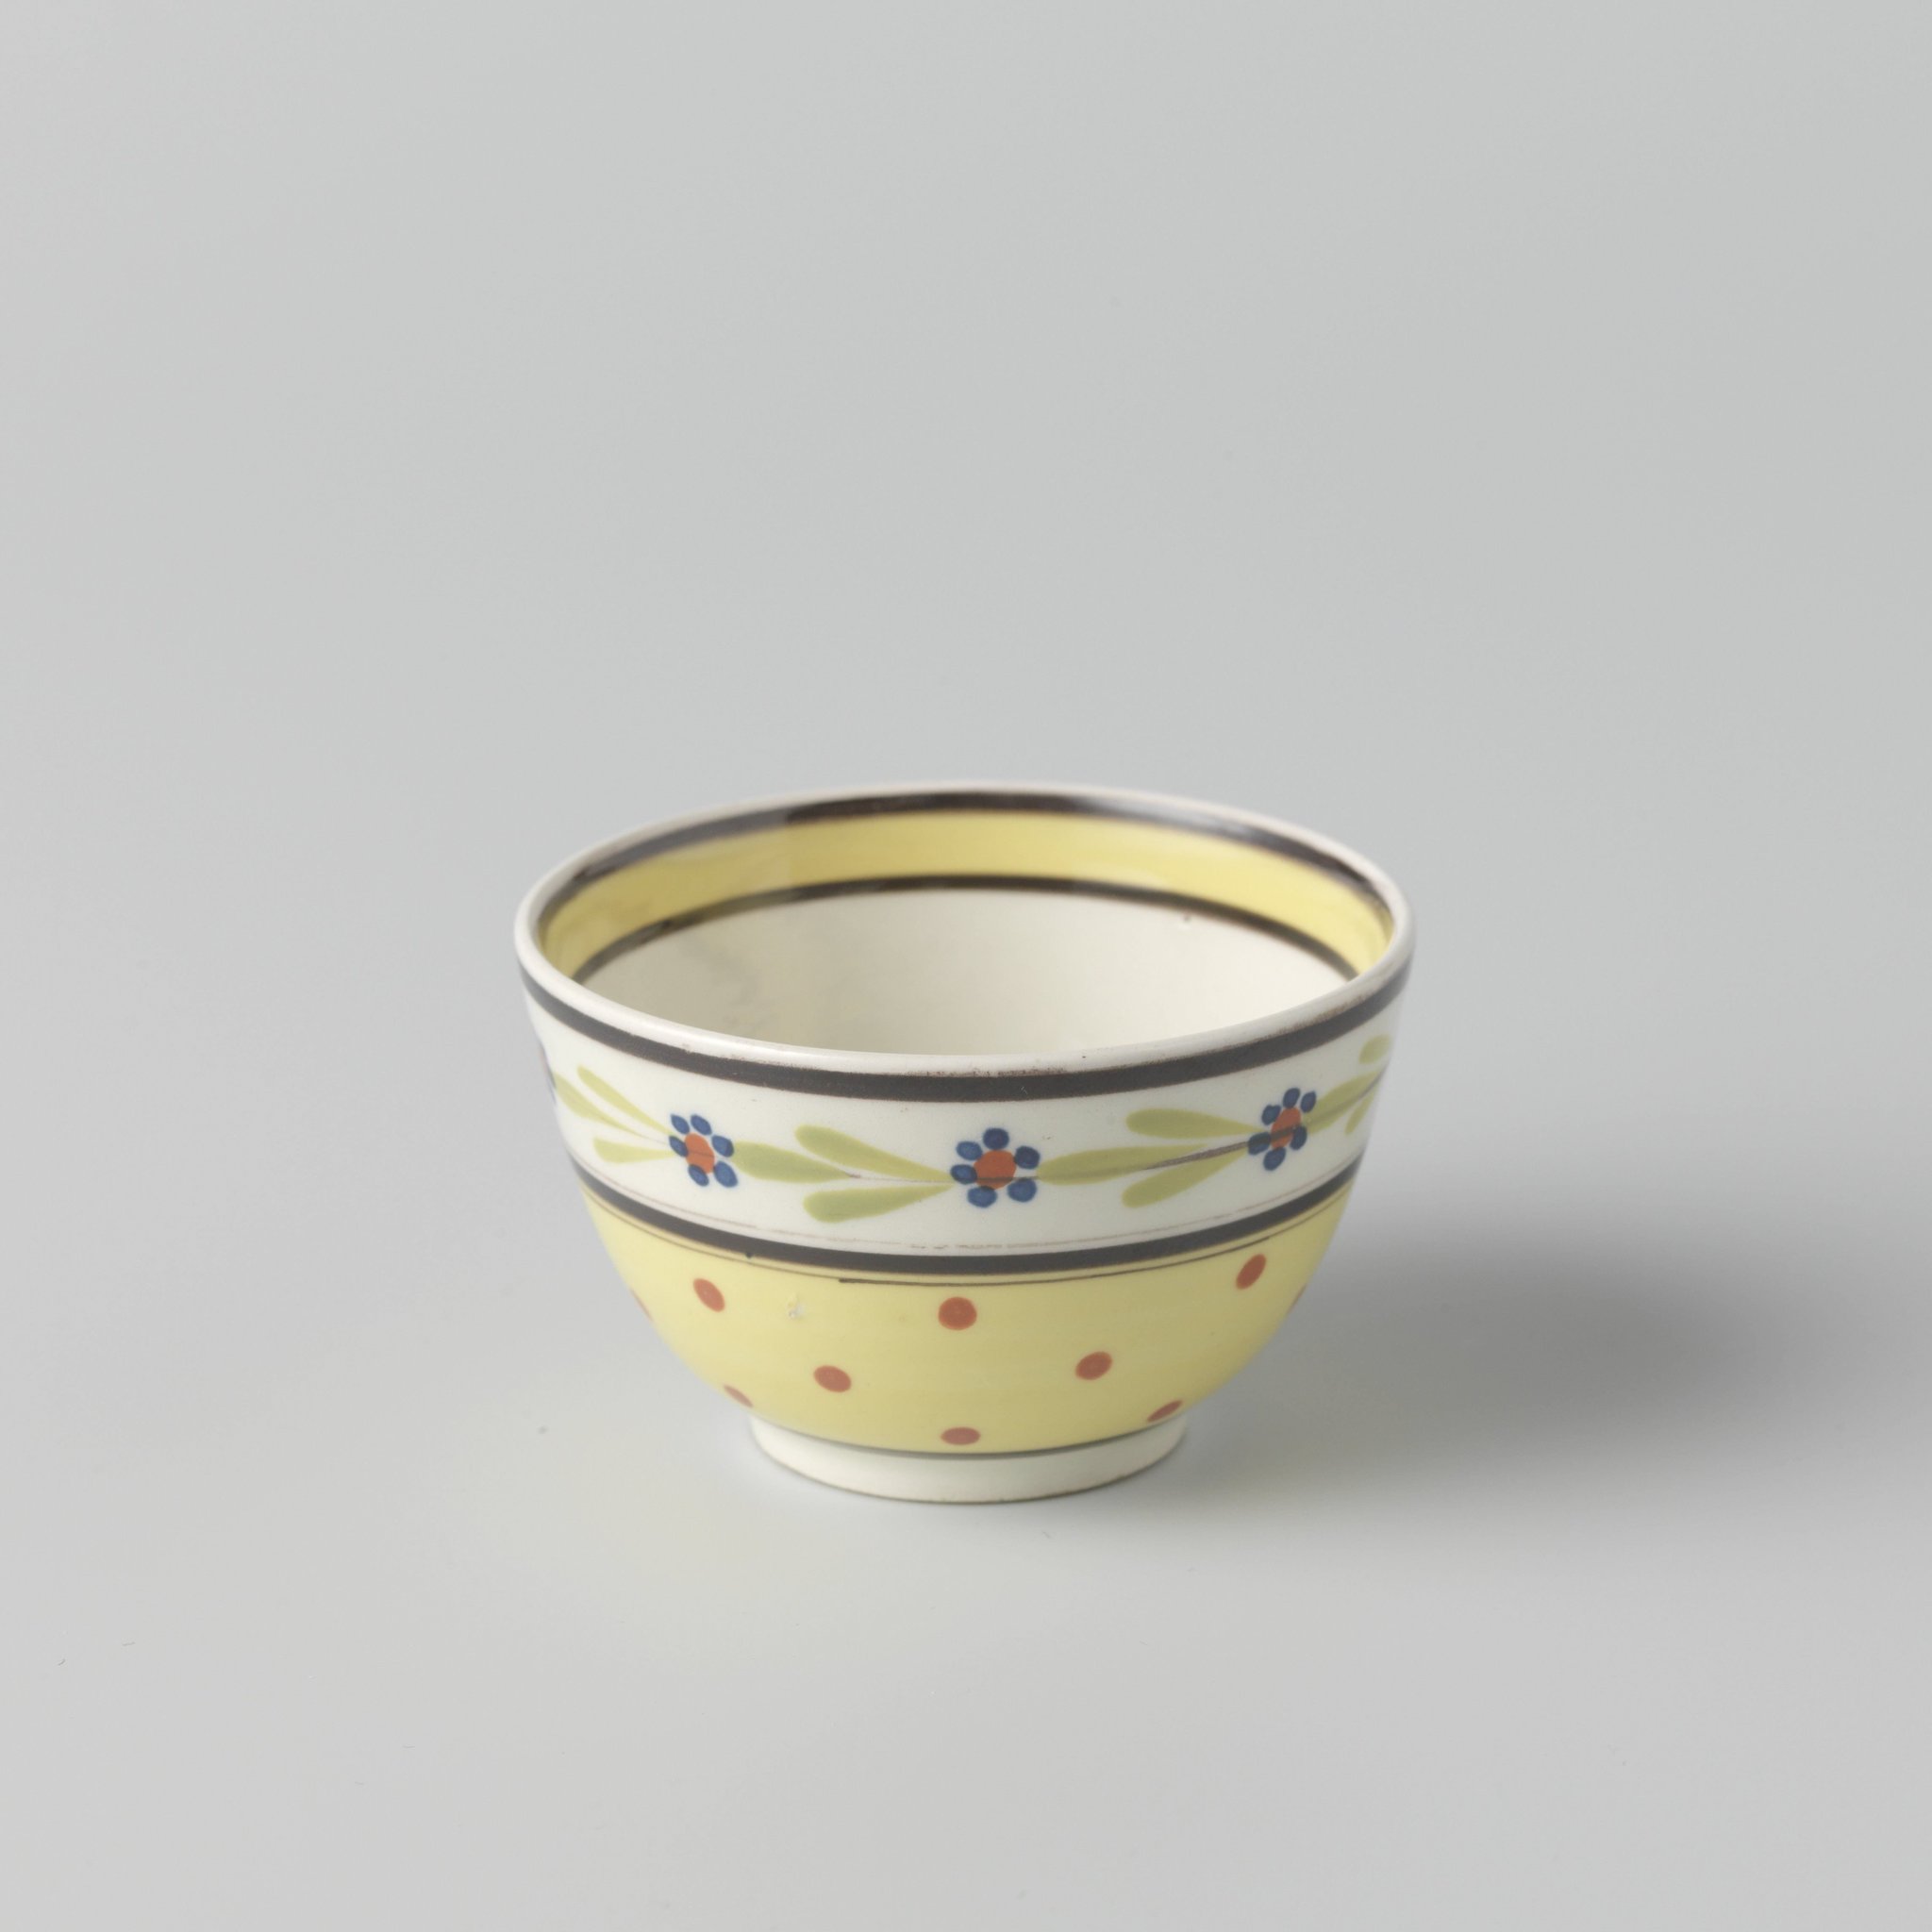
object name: cup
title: Halfbolvormige kop van hardgebakken aardewerk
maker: Anonymous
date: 1800-1830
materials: earthenware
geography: england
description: Halfbolvormige kop van hardgebakken aardewerk, veelkleurig beschilderd. Langs de rand loopt een band gestileerde bladeren waartussen een gestileerde bloem, bestaande uit stippen. Onder de band is de kop beschilderd met stippen. Bij de kop hoort een kop met gelijke vorm maar andere decoratie met invnr. BK-NM-7527-B.